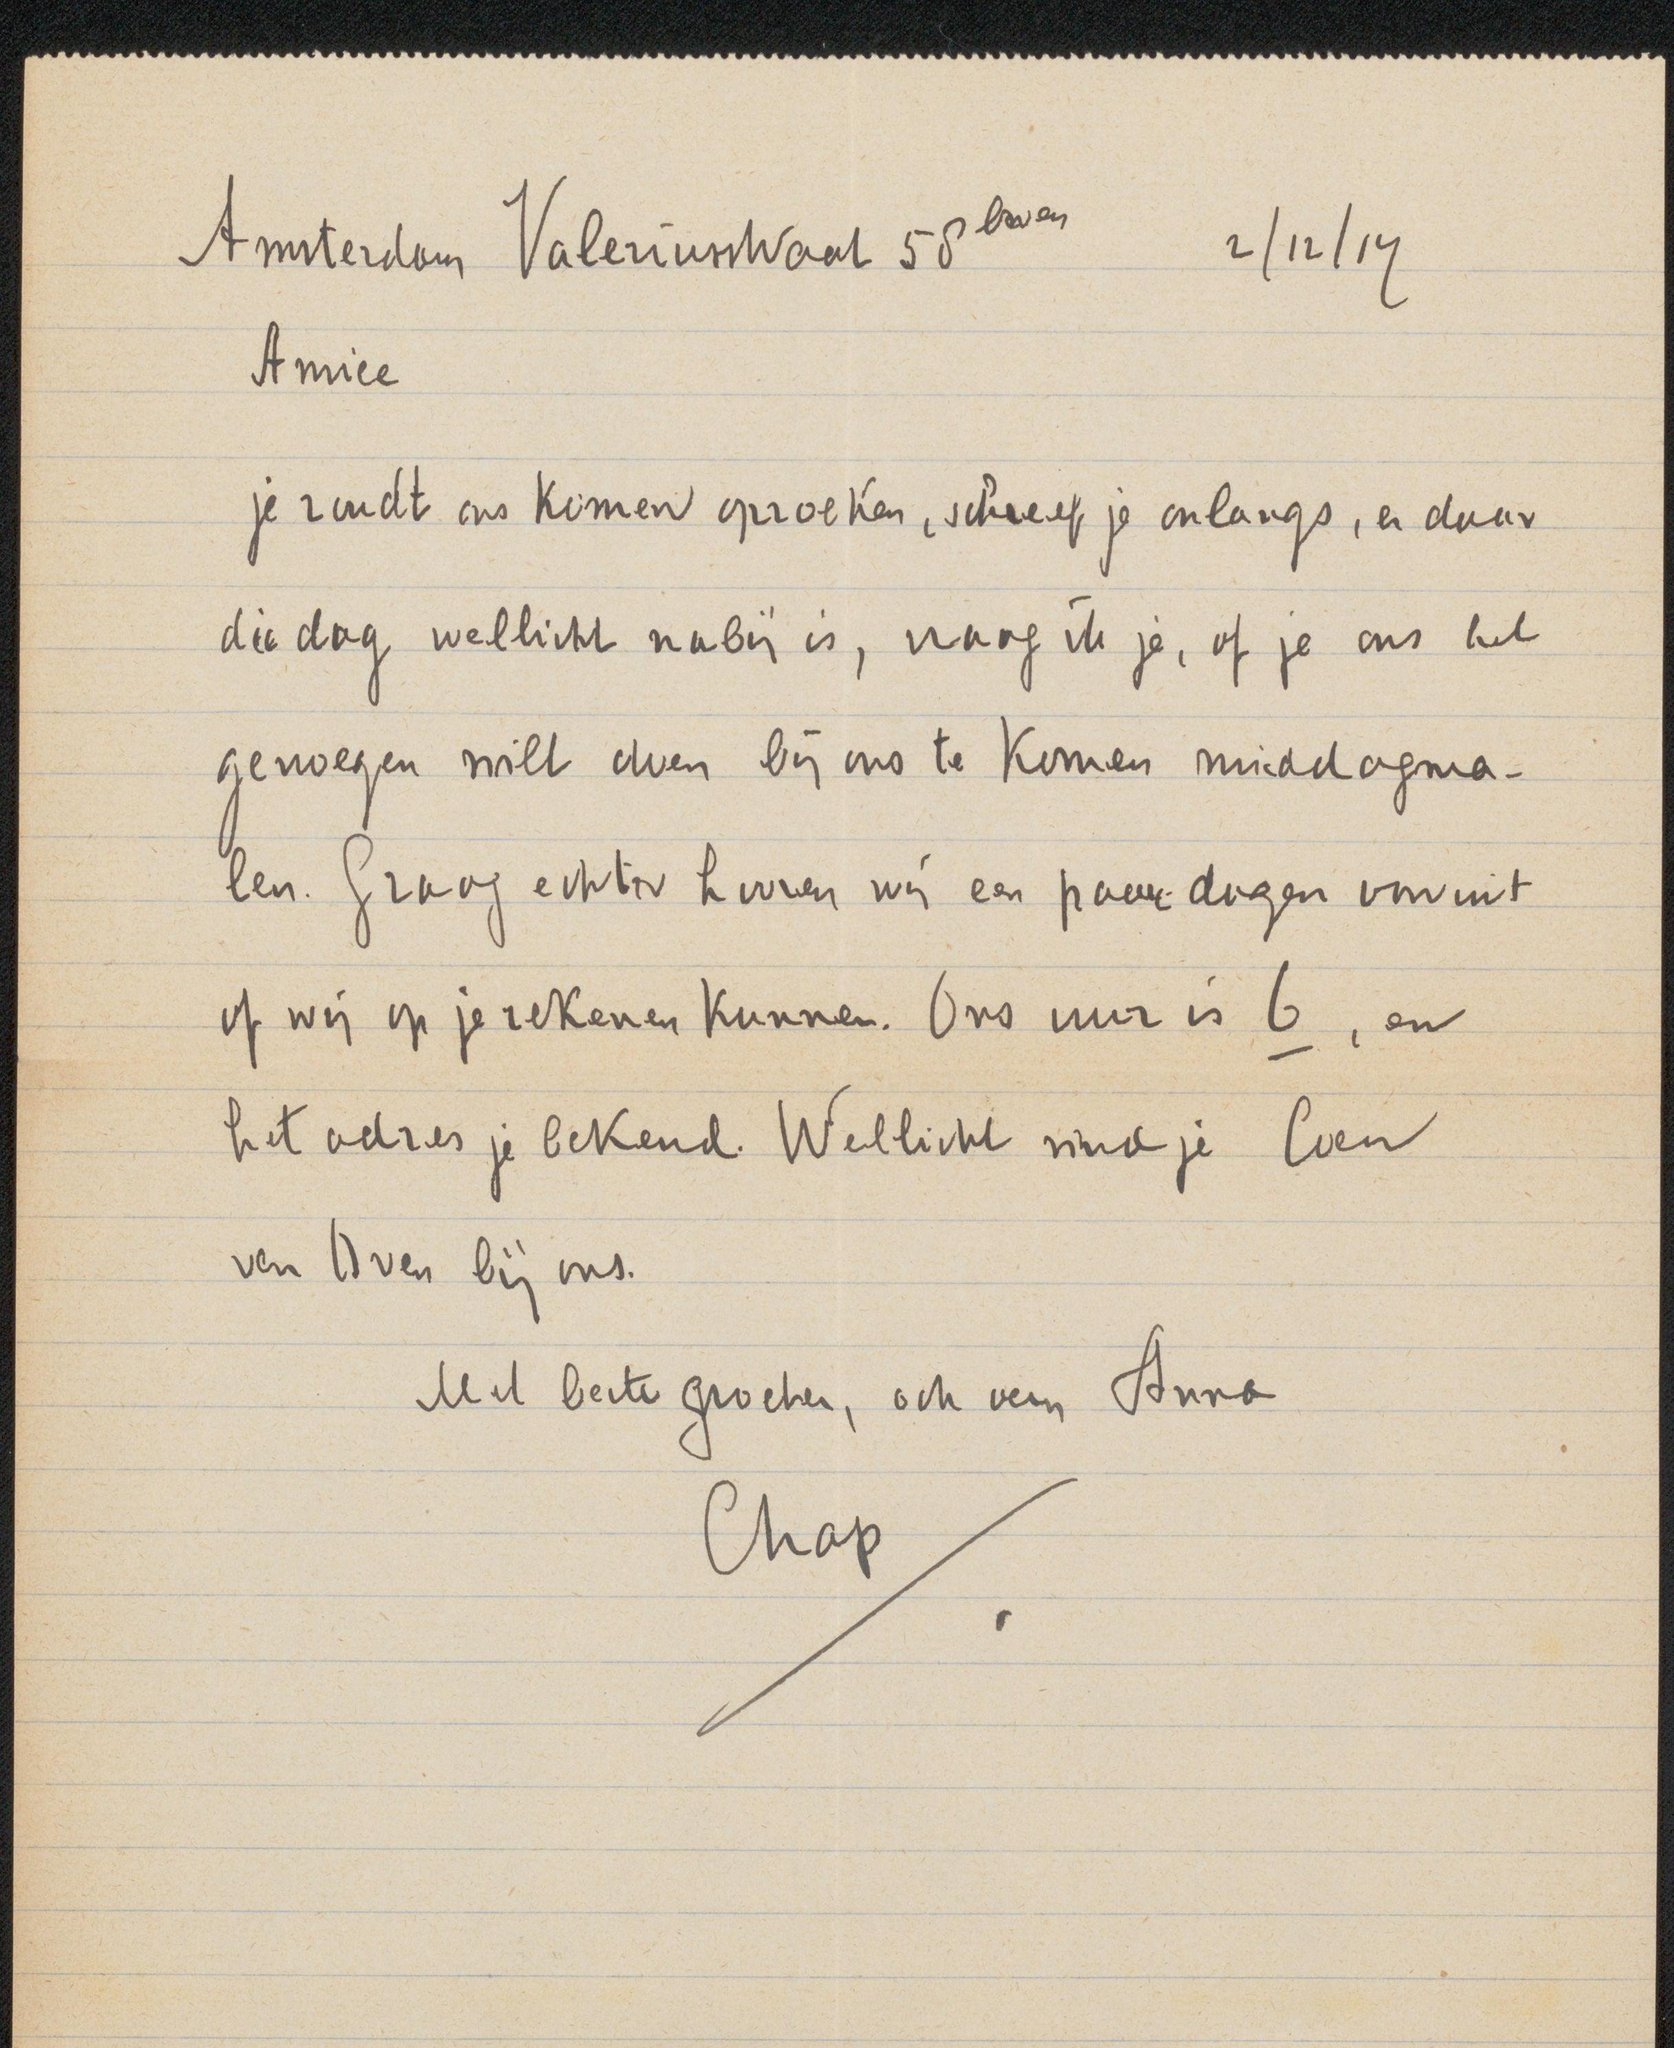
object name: letter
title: Brief aan Jan Veth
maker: chap van deventer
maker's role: kunstcriticus, scheikundige, schrijver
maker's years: 1860-1931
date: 1917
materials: ink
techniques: pen, writing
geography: amsterdam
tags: painter, print maker, jan veth, amsterdam, draughtsman, coen van oven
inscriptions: collector's mark: ‘RPK’